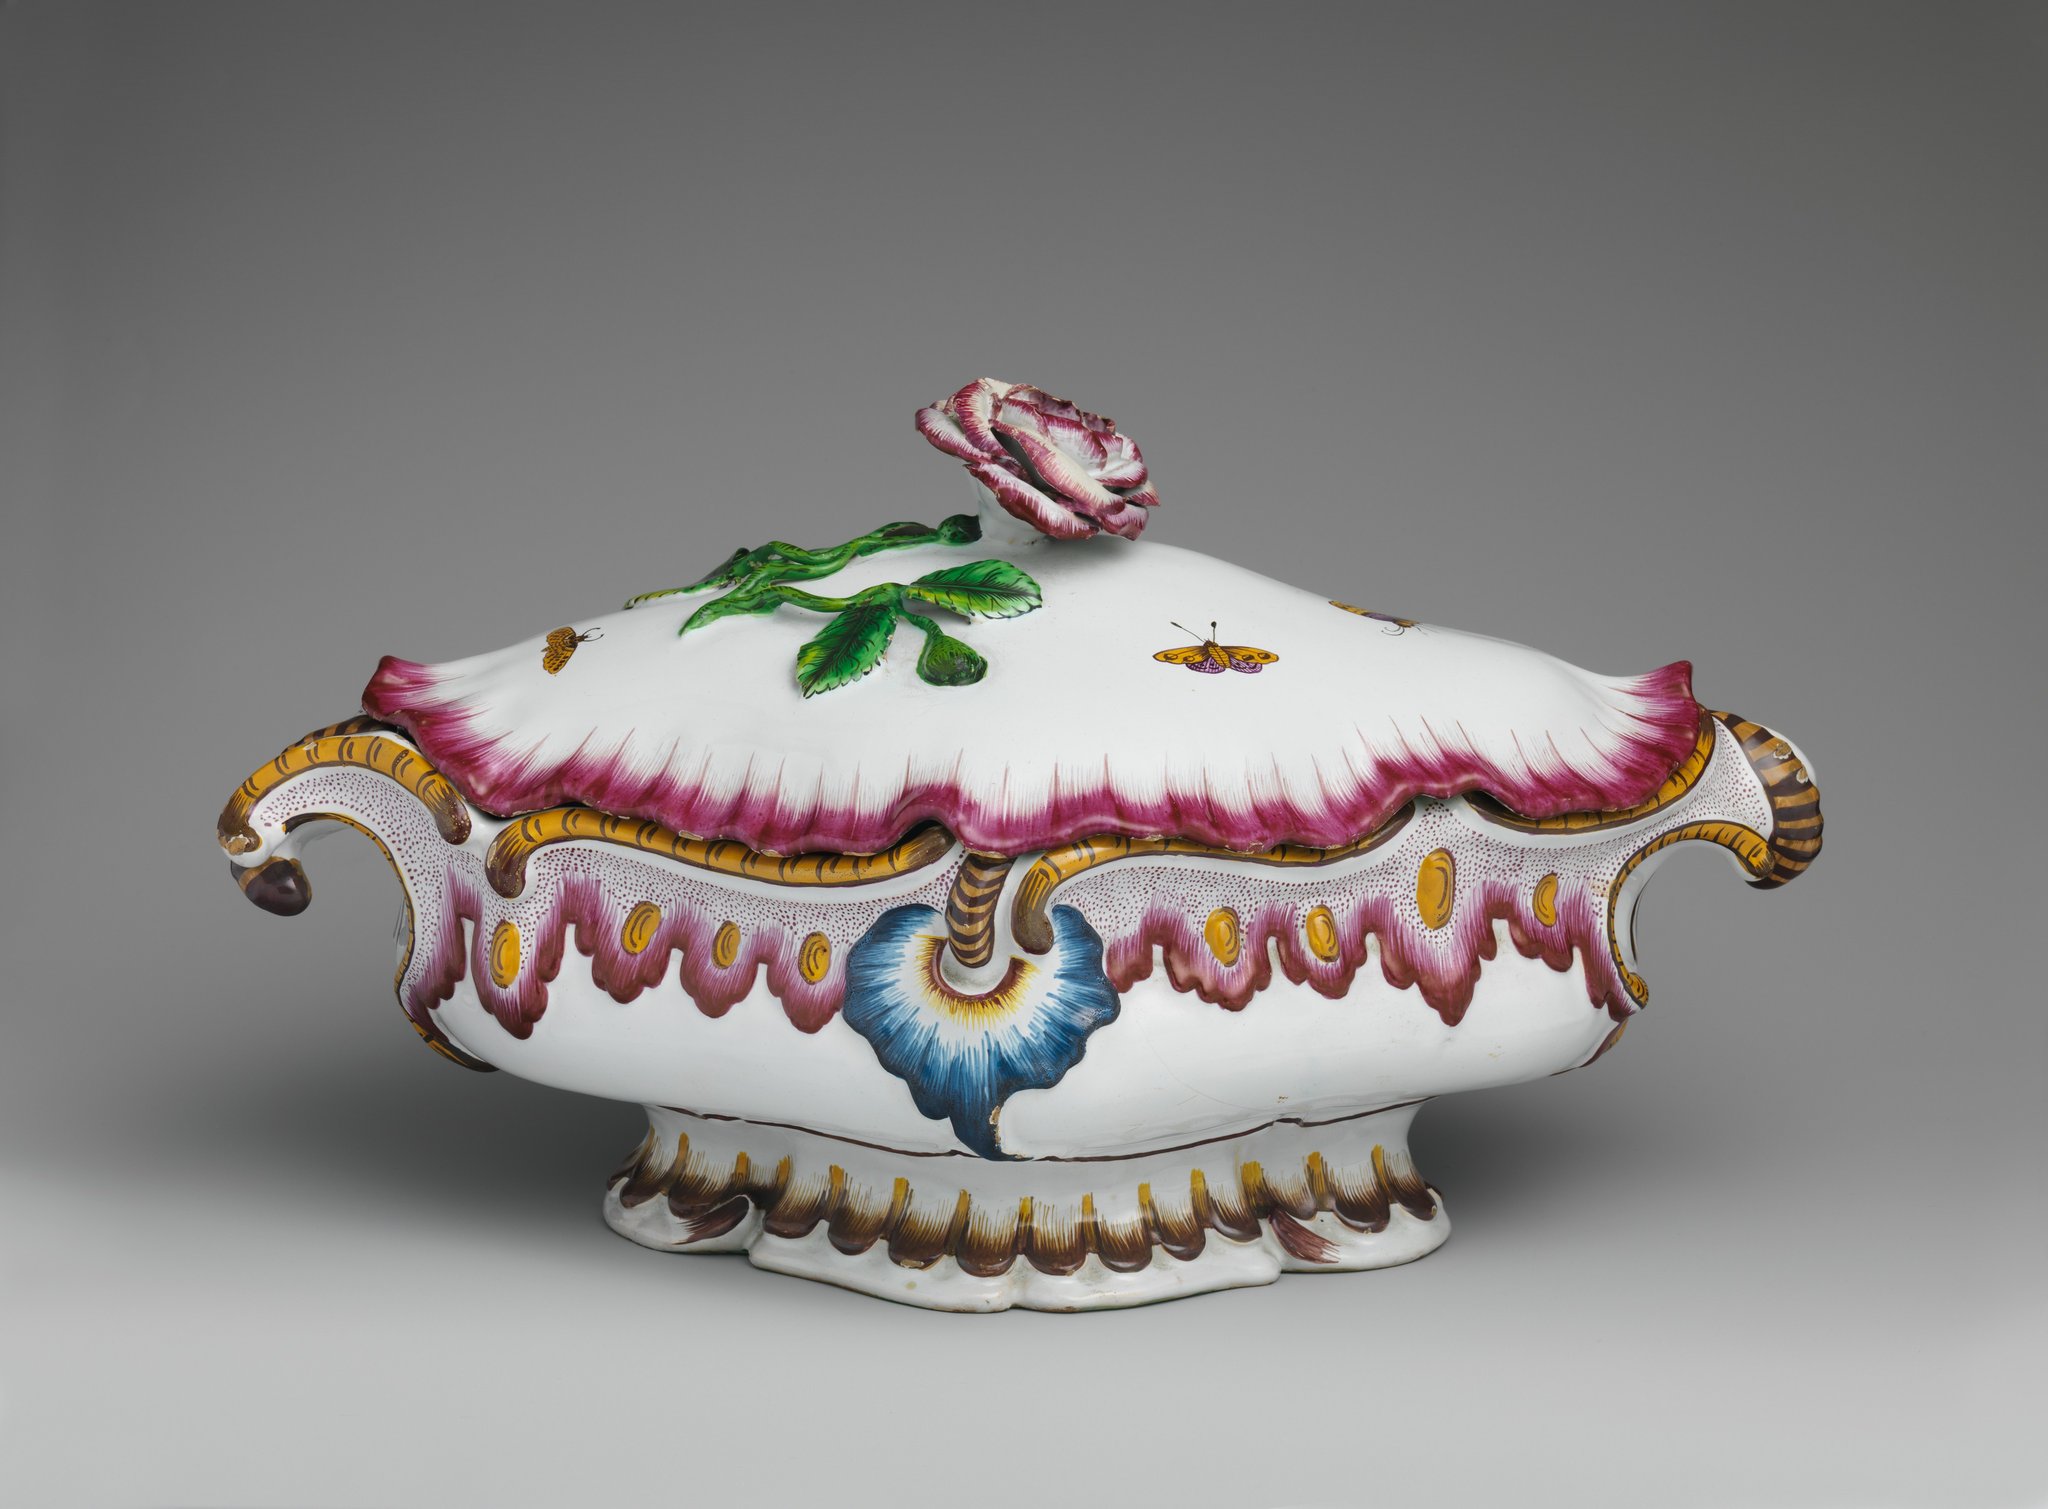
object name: tureen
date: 1750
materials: faience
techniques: glazing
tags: roses